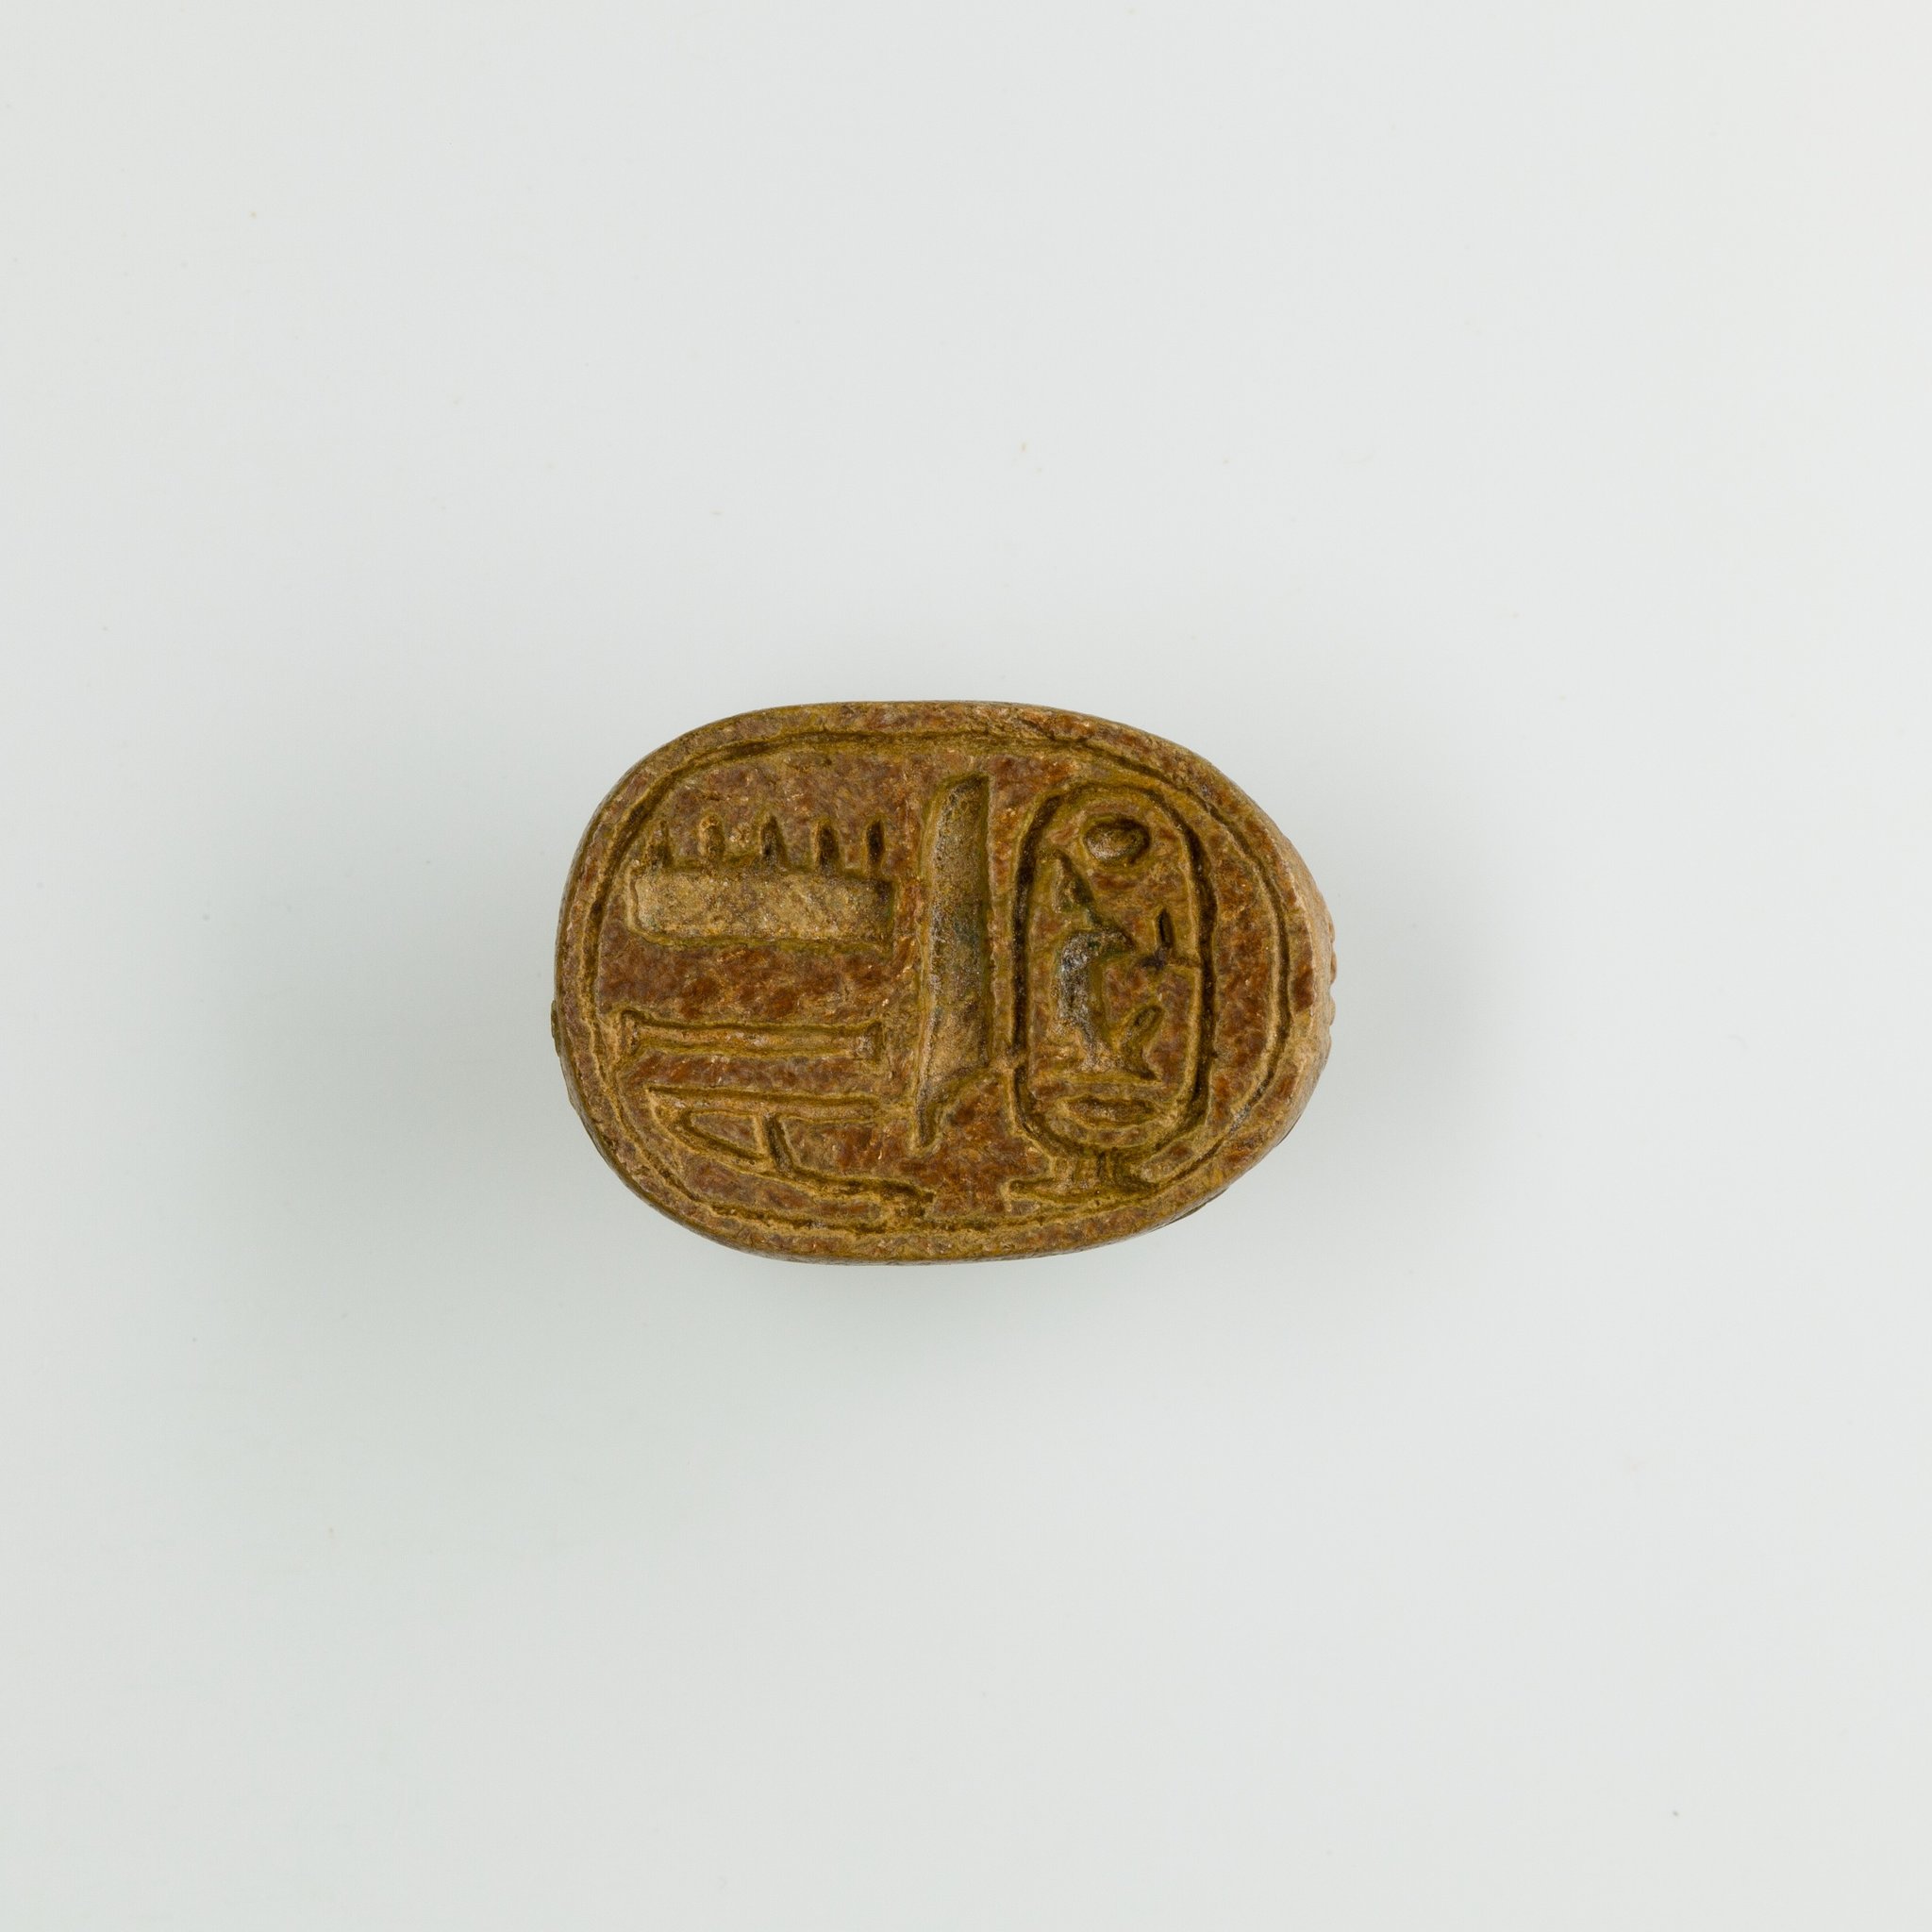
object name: scarab, amenhotep i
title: Scarab of Amenhotep III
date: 1295-1070 BCE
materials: stone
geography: egypt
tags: hieroglyphs,scarabs